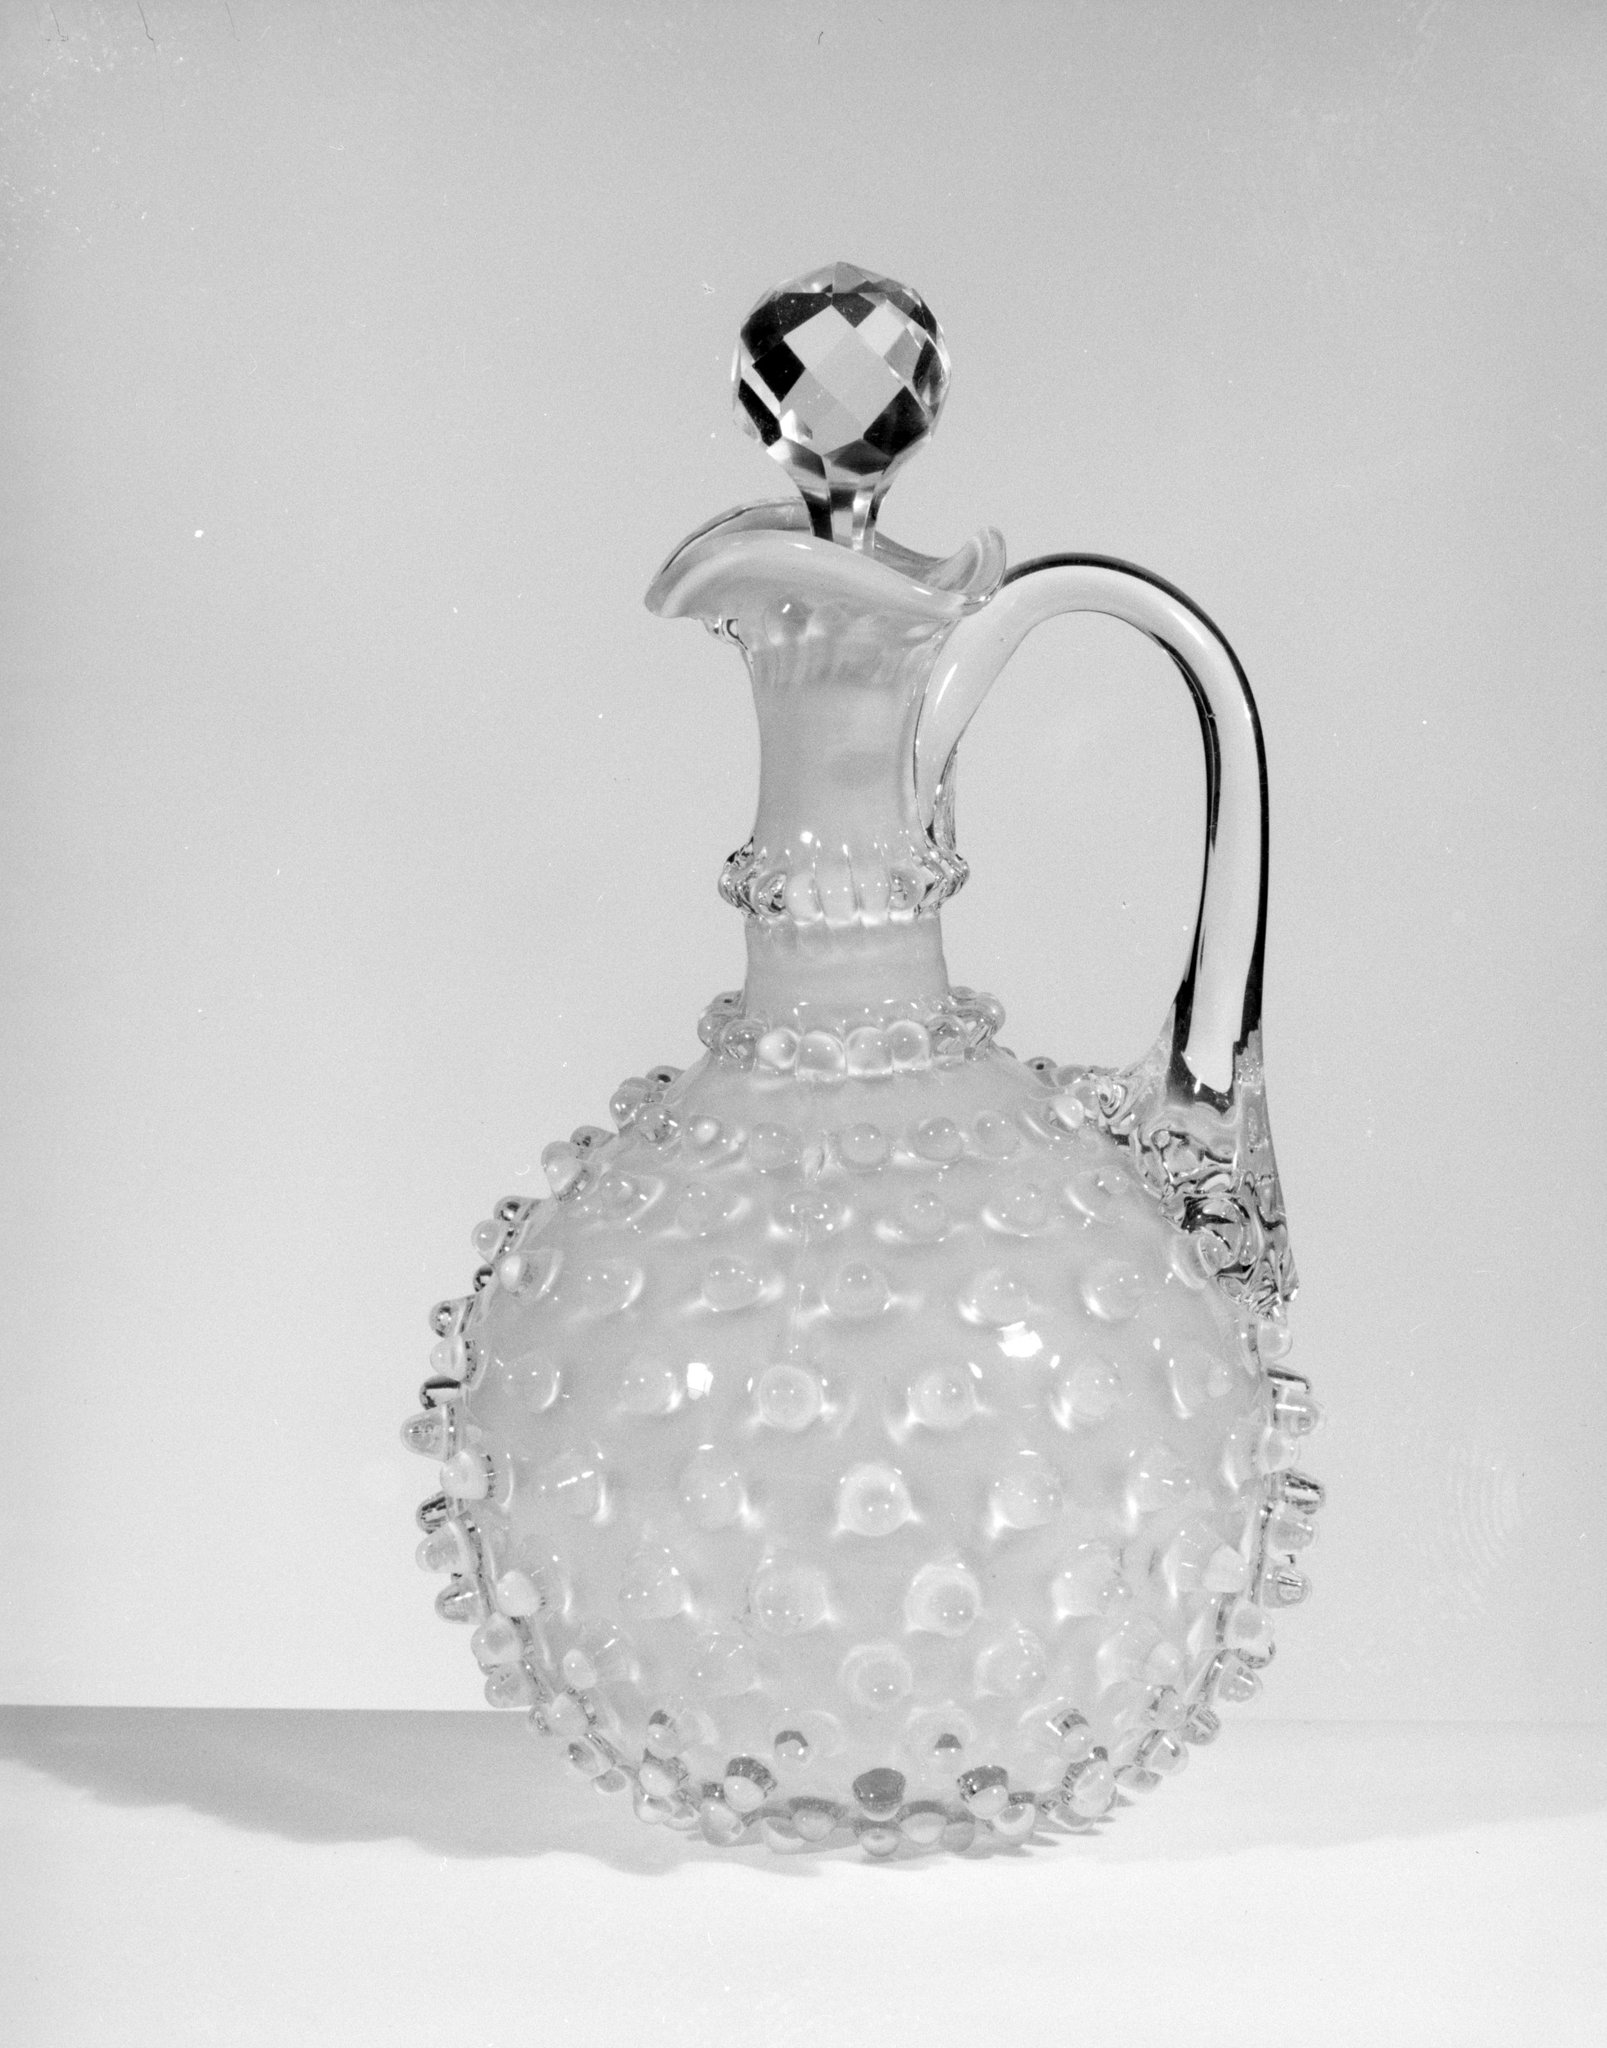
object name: cruet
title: Hobnail Cruet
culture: american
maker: hobbs, brockunier and company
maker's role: maker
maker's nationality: american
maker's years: 1863-1891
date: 1886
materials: glass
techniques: pressed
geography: united states